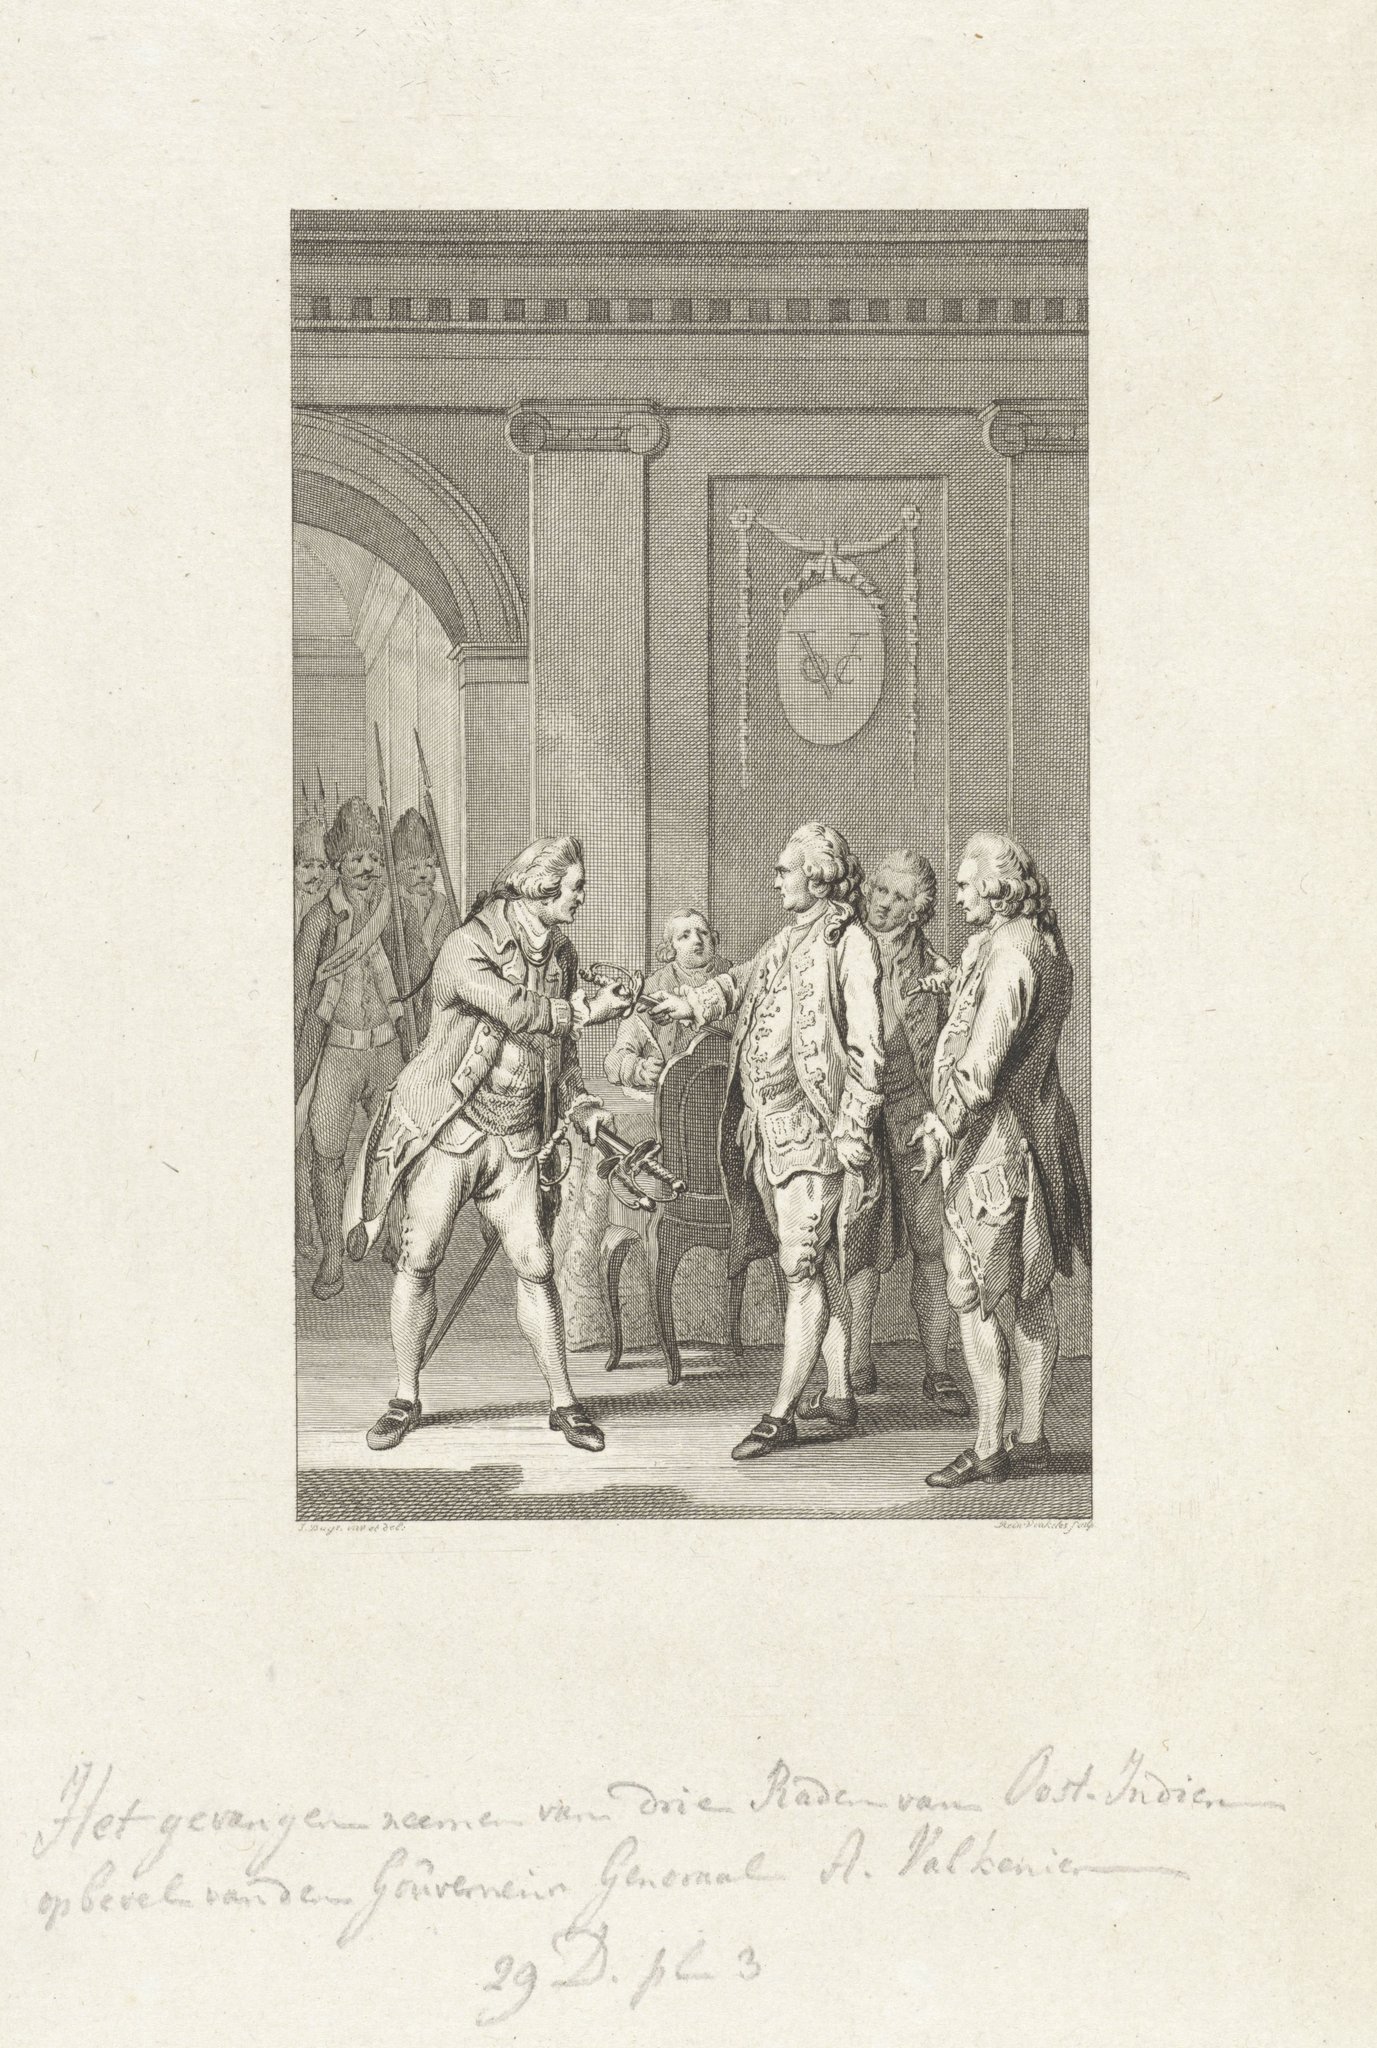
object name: print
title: Gevangenneming van drie raden van de VOC, 1740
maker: reinier vinkeles (i)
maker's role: draughtsman, print maker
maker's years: 1741-1816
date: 1793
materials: paper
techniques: engraving, etching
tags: arrest (of criminal), batavia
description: De gevangenneming van drie leden van de Raad van Indie in Batavia Gustaaf Willem van Imhoff, Isaac van Schinne en Elias Haese op bevel van de gouverneur-generaal Adriaan Valkenier, december 1740.